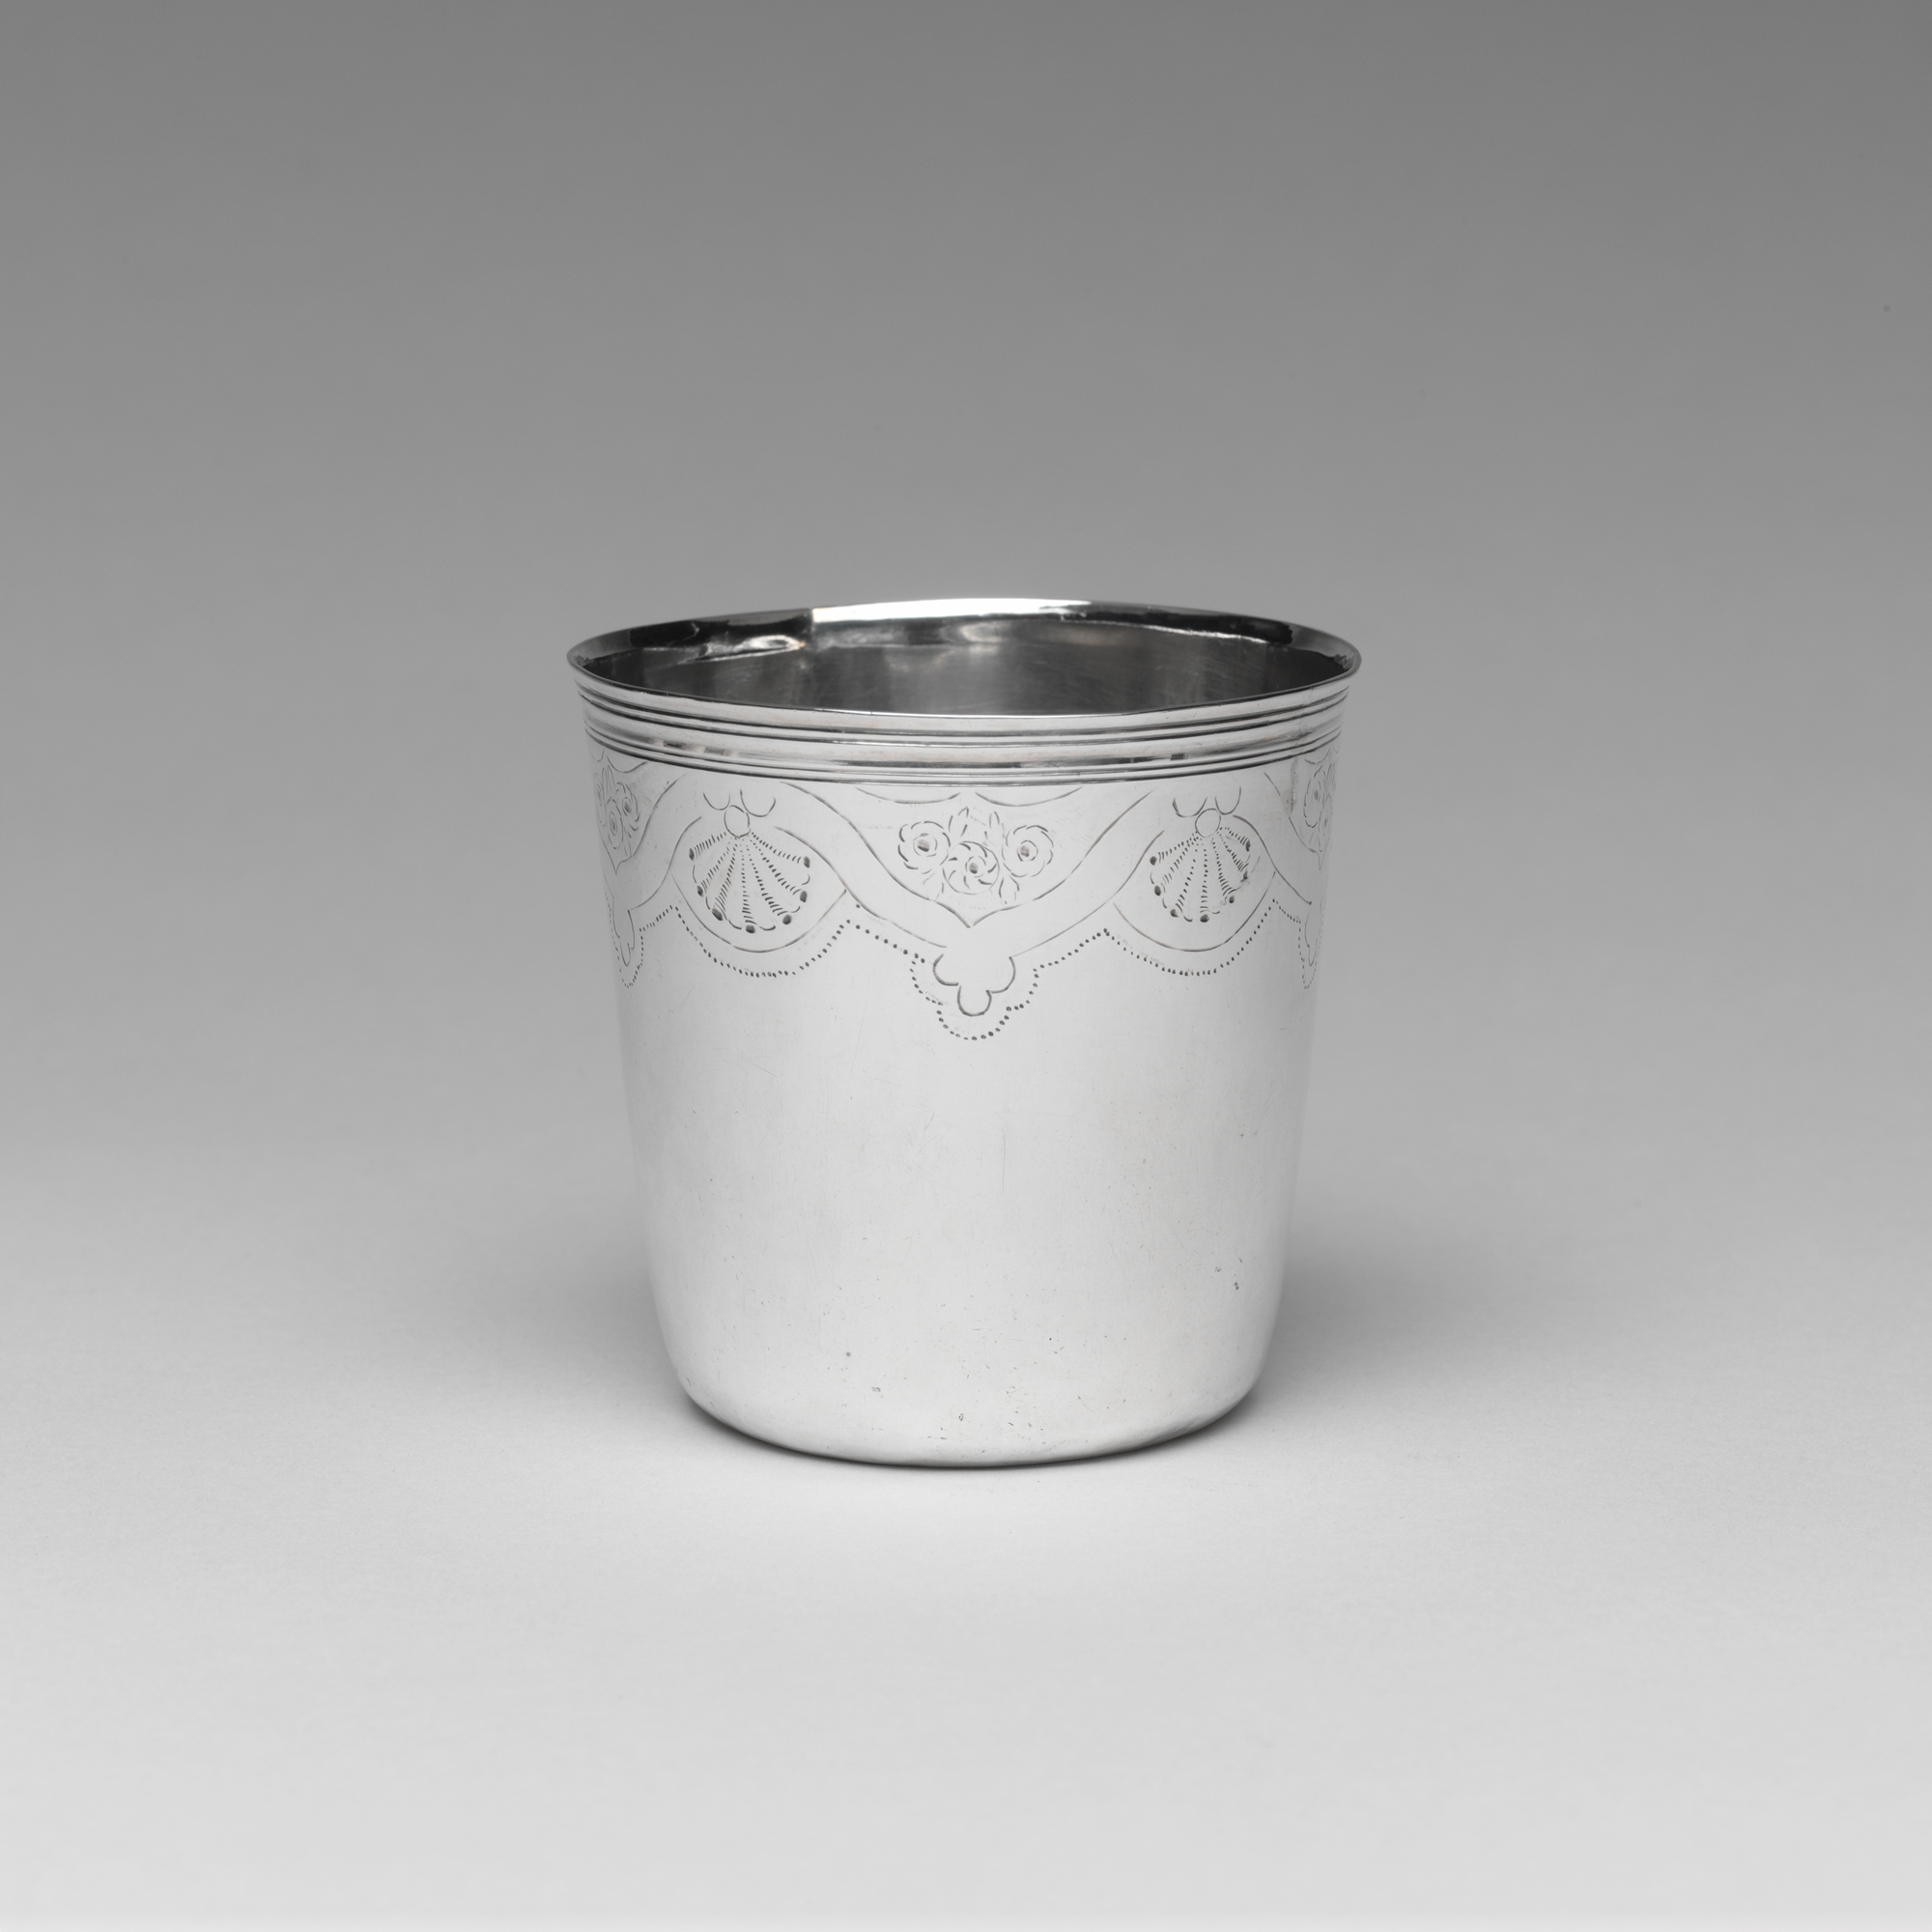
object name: tumbler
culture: american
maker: paul revere jr.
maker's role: maker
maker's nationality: american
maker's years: 1734-1818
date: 1797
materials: silver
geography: united states